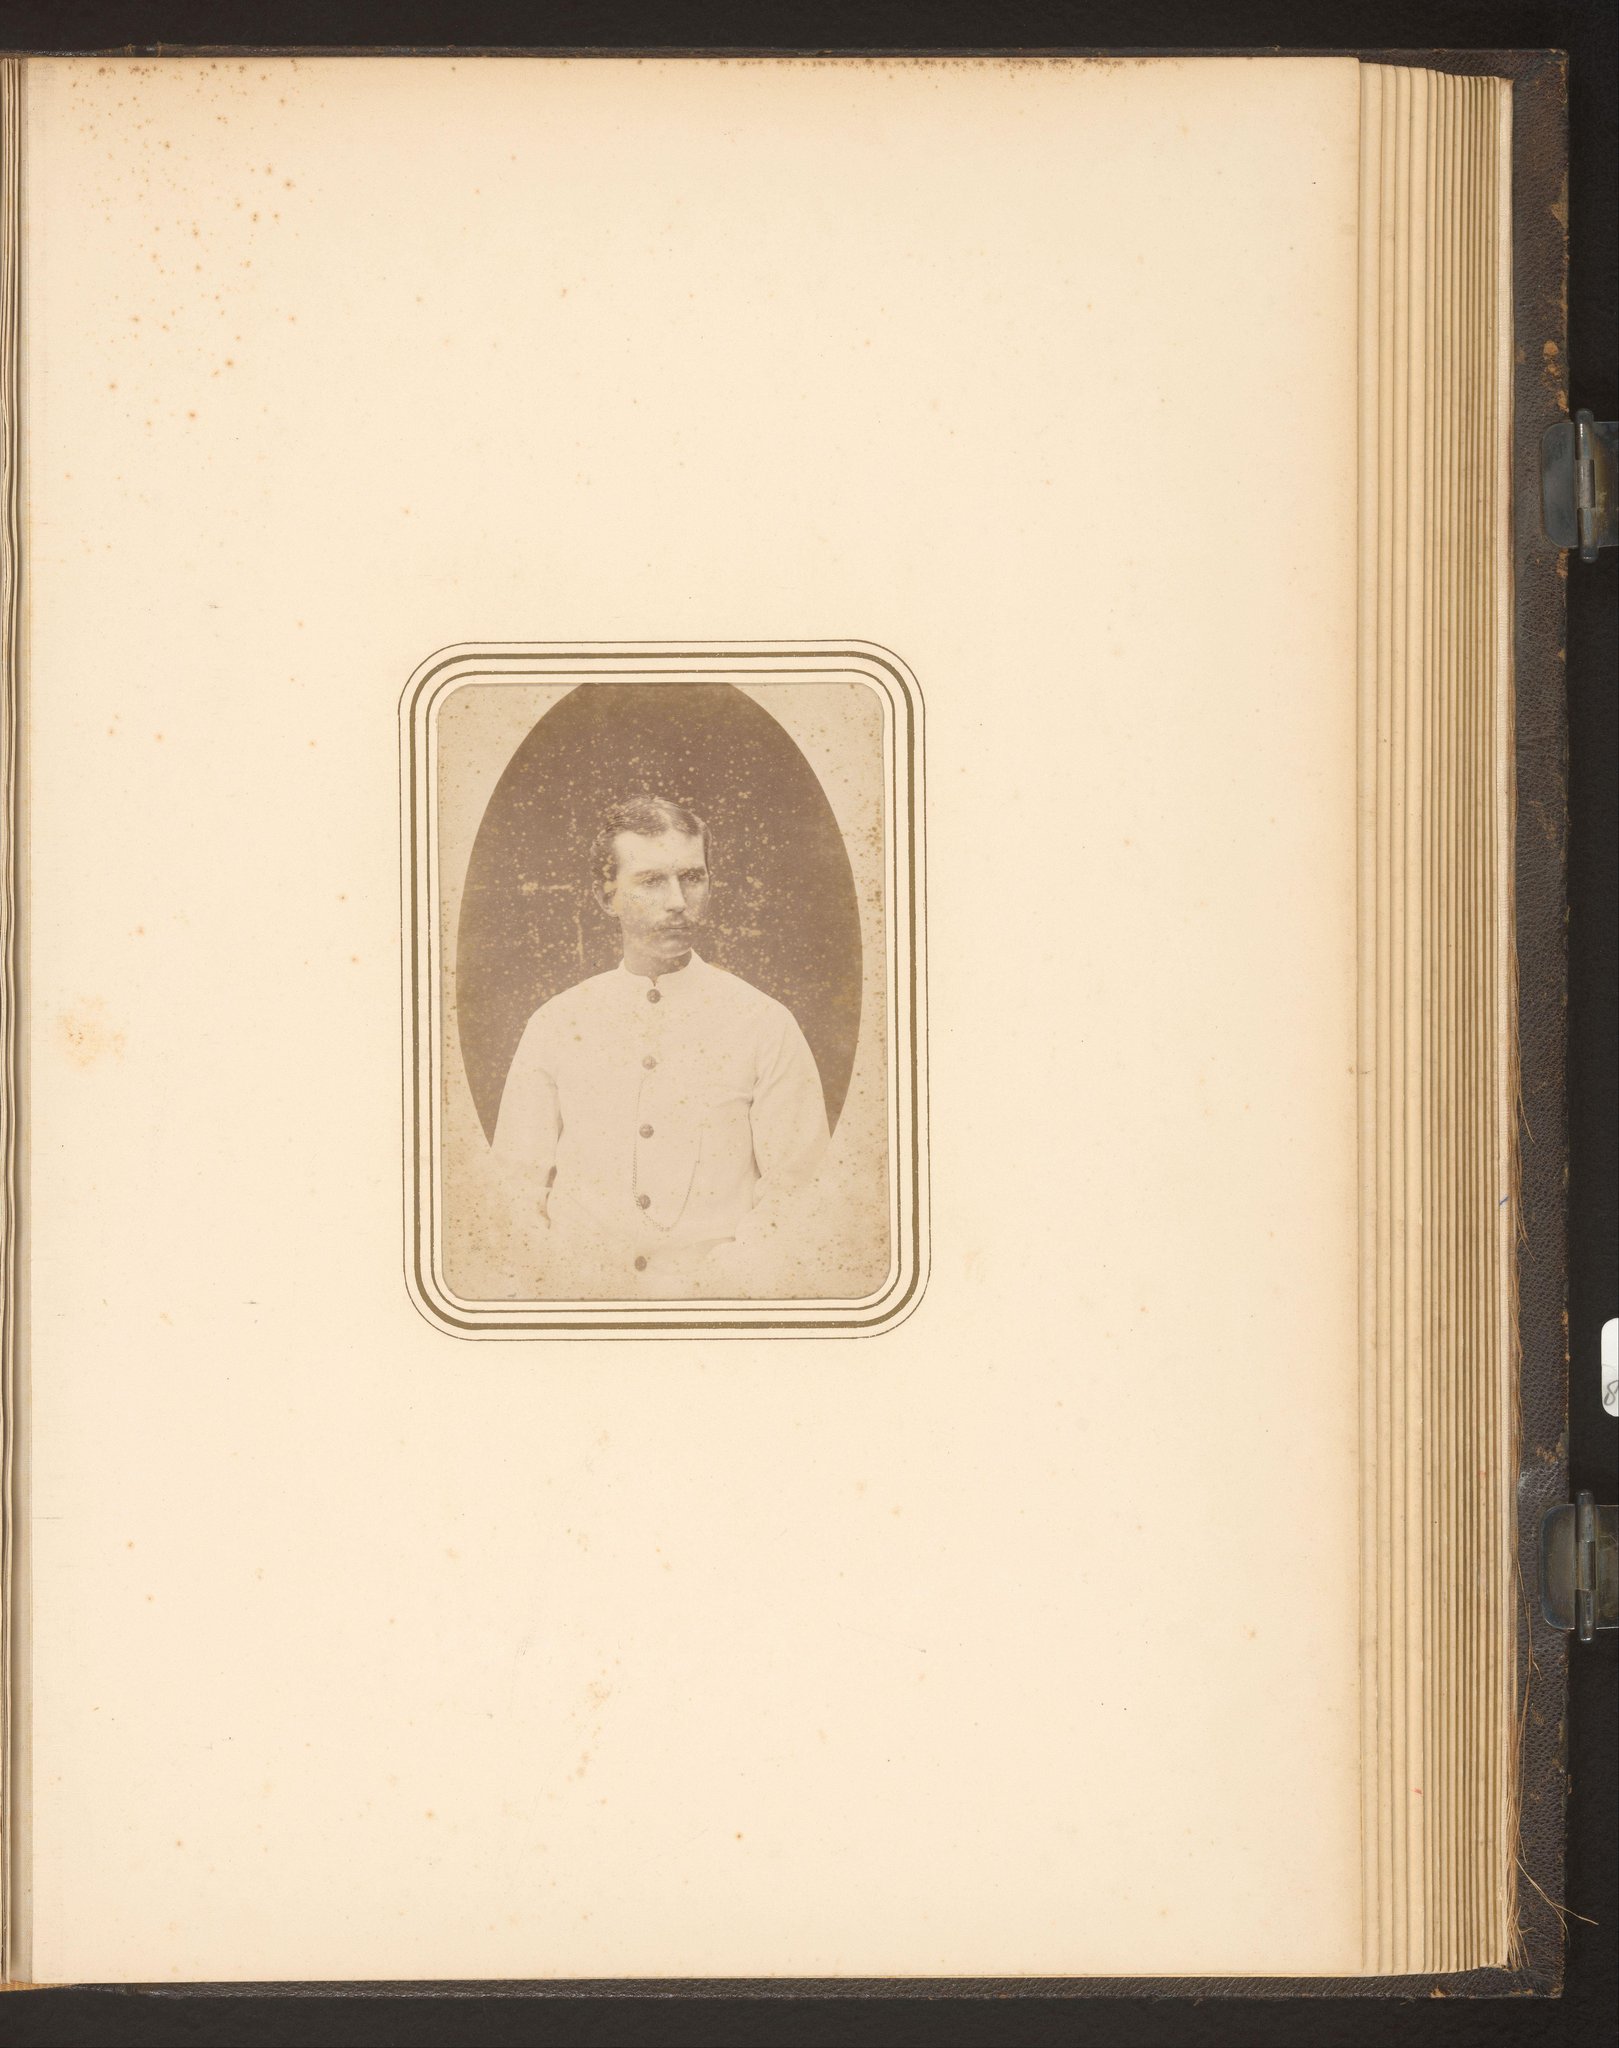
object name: cabinet photograph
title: Portret van onbekende man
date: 1882-1887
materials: cardboard, photographic support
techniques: albumen print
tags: historical persons not known by name, sumatra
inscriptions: name: ‘G.R. Lambert & Co. Photographers by appointment to H.M. the King of Siam and to H.H. the Maharajah of Johore’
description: Portret van een onbekende man. Ingestoken foto in het herinneringsalbum aangeboden door de Tabak Maatschappij Arendsburg aan hoofdadministrateur M.J. Tiele bij zijn terugkeer naar Nederland in 1887.